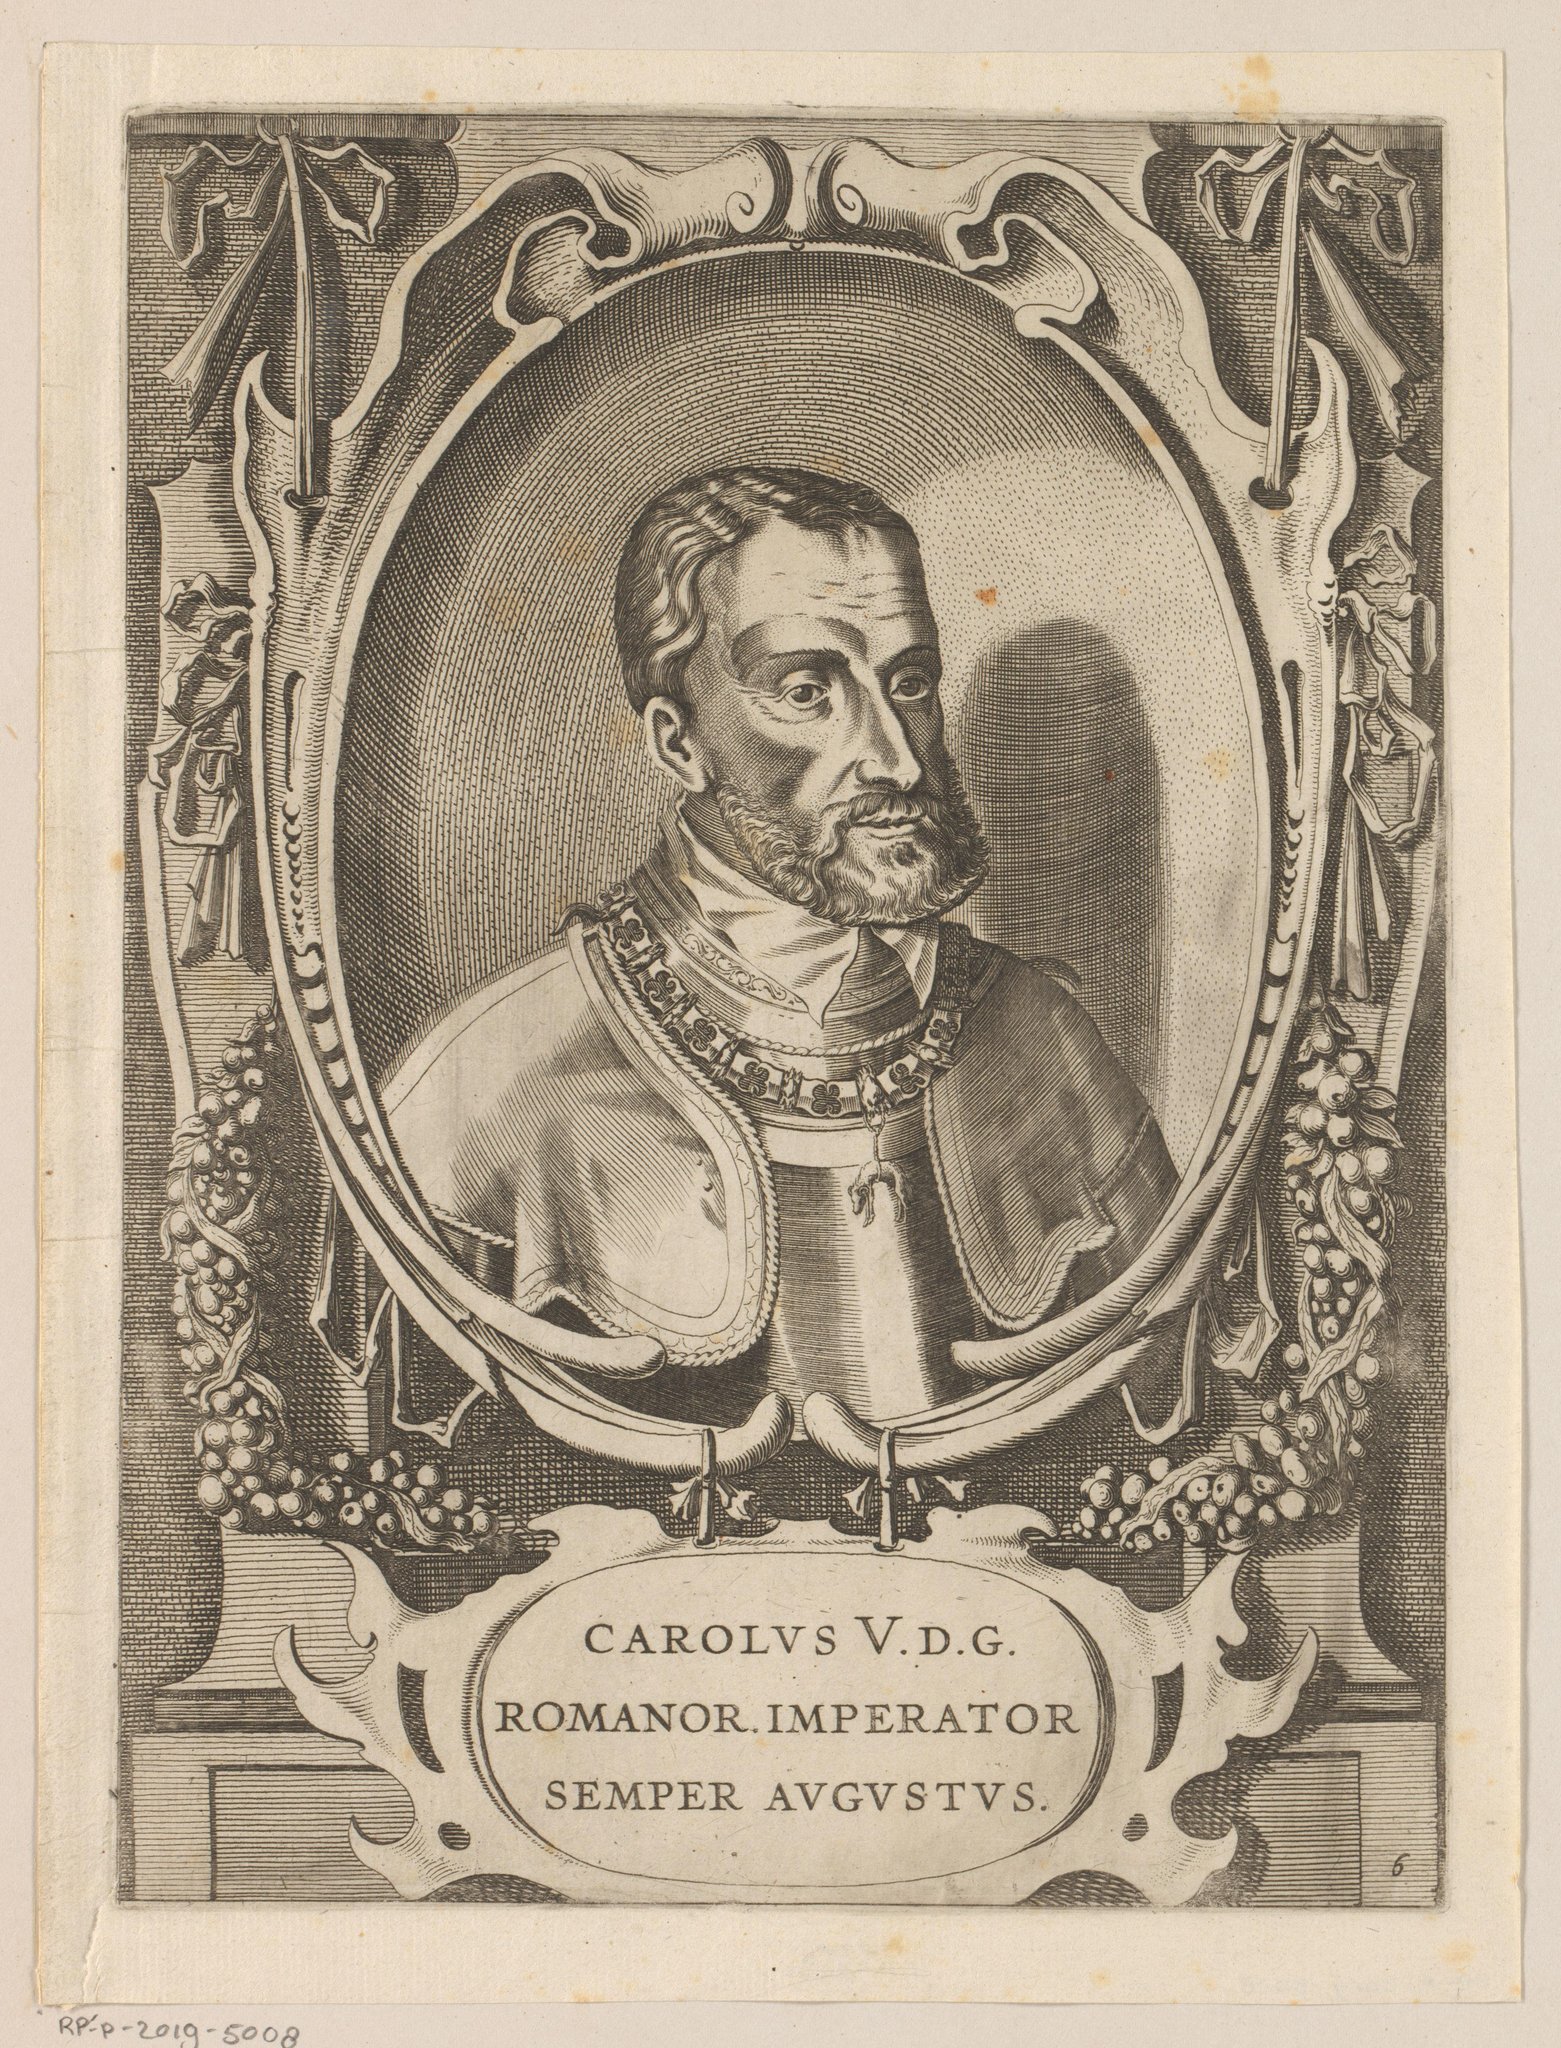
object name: print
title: Portret van keizer Karel V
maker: Anonymous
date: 1600-1699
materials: paper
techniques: engraving, etching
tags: ghent, charles v (holy roman emperor and king of spain), armour, historical persons, knighthood order of the golden fleece - insignia of a knighthood order, e.g.: badge, chain (with name of order)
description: Met om zijn nek de keten van de Orde van het Gulden Vlies. Rechtsonder genummerd: 6.